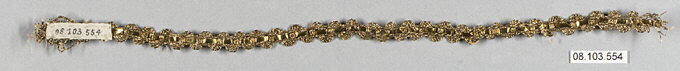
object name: galloon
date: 1734-1766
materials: cotton